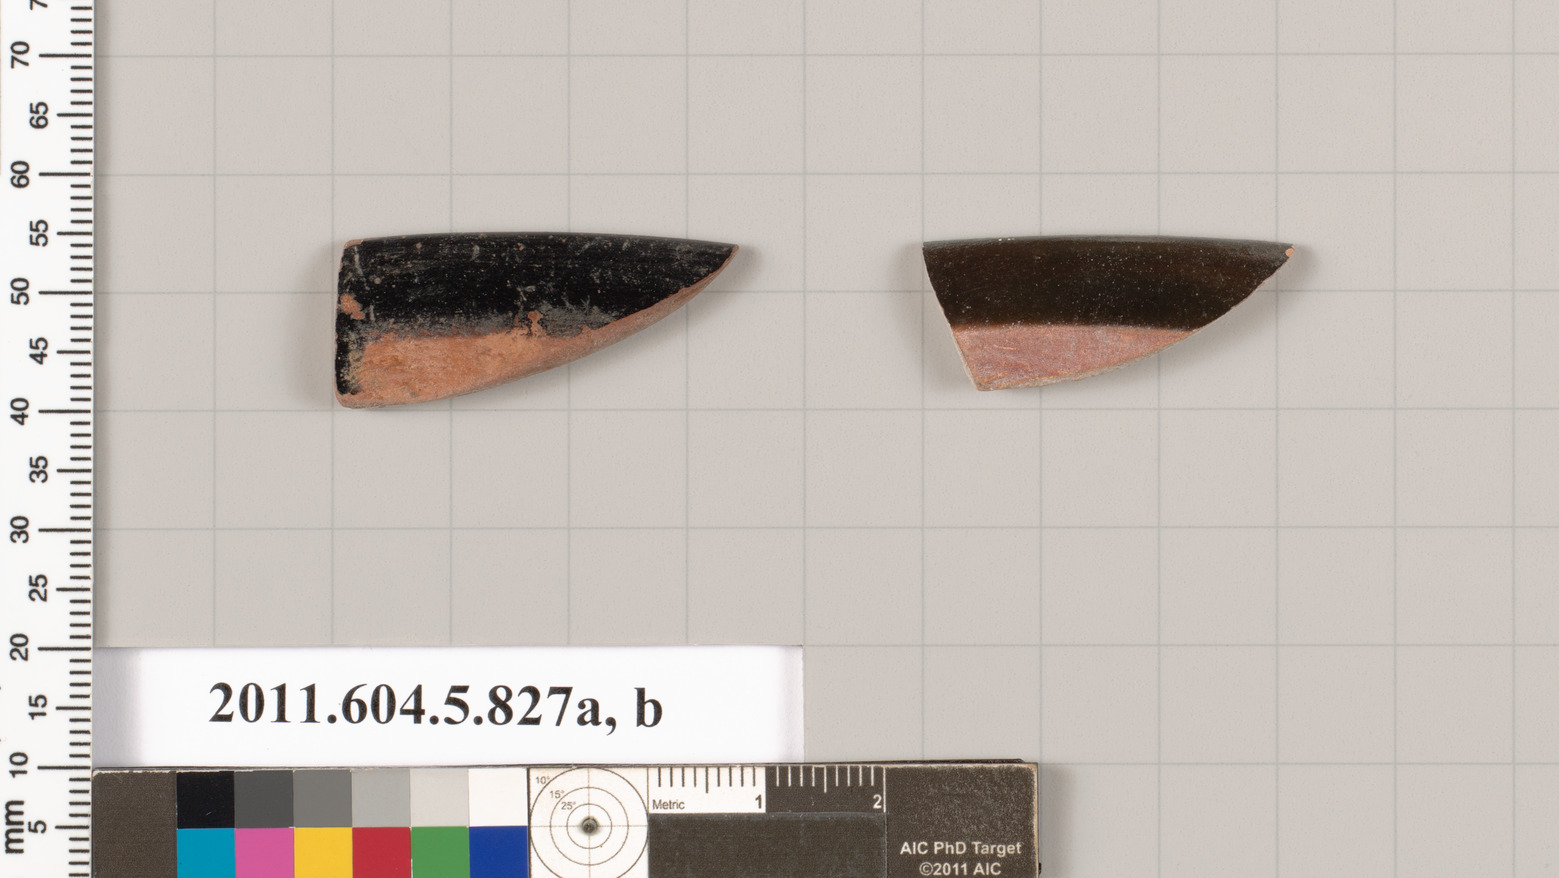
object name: kylix fragment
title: Terracotta rim fragments of kylikes (drinking cups)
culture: greek, attic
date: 600-401 BCE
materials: terracotta